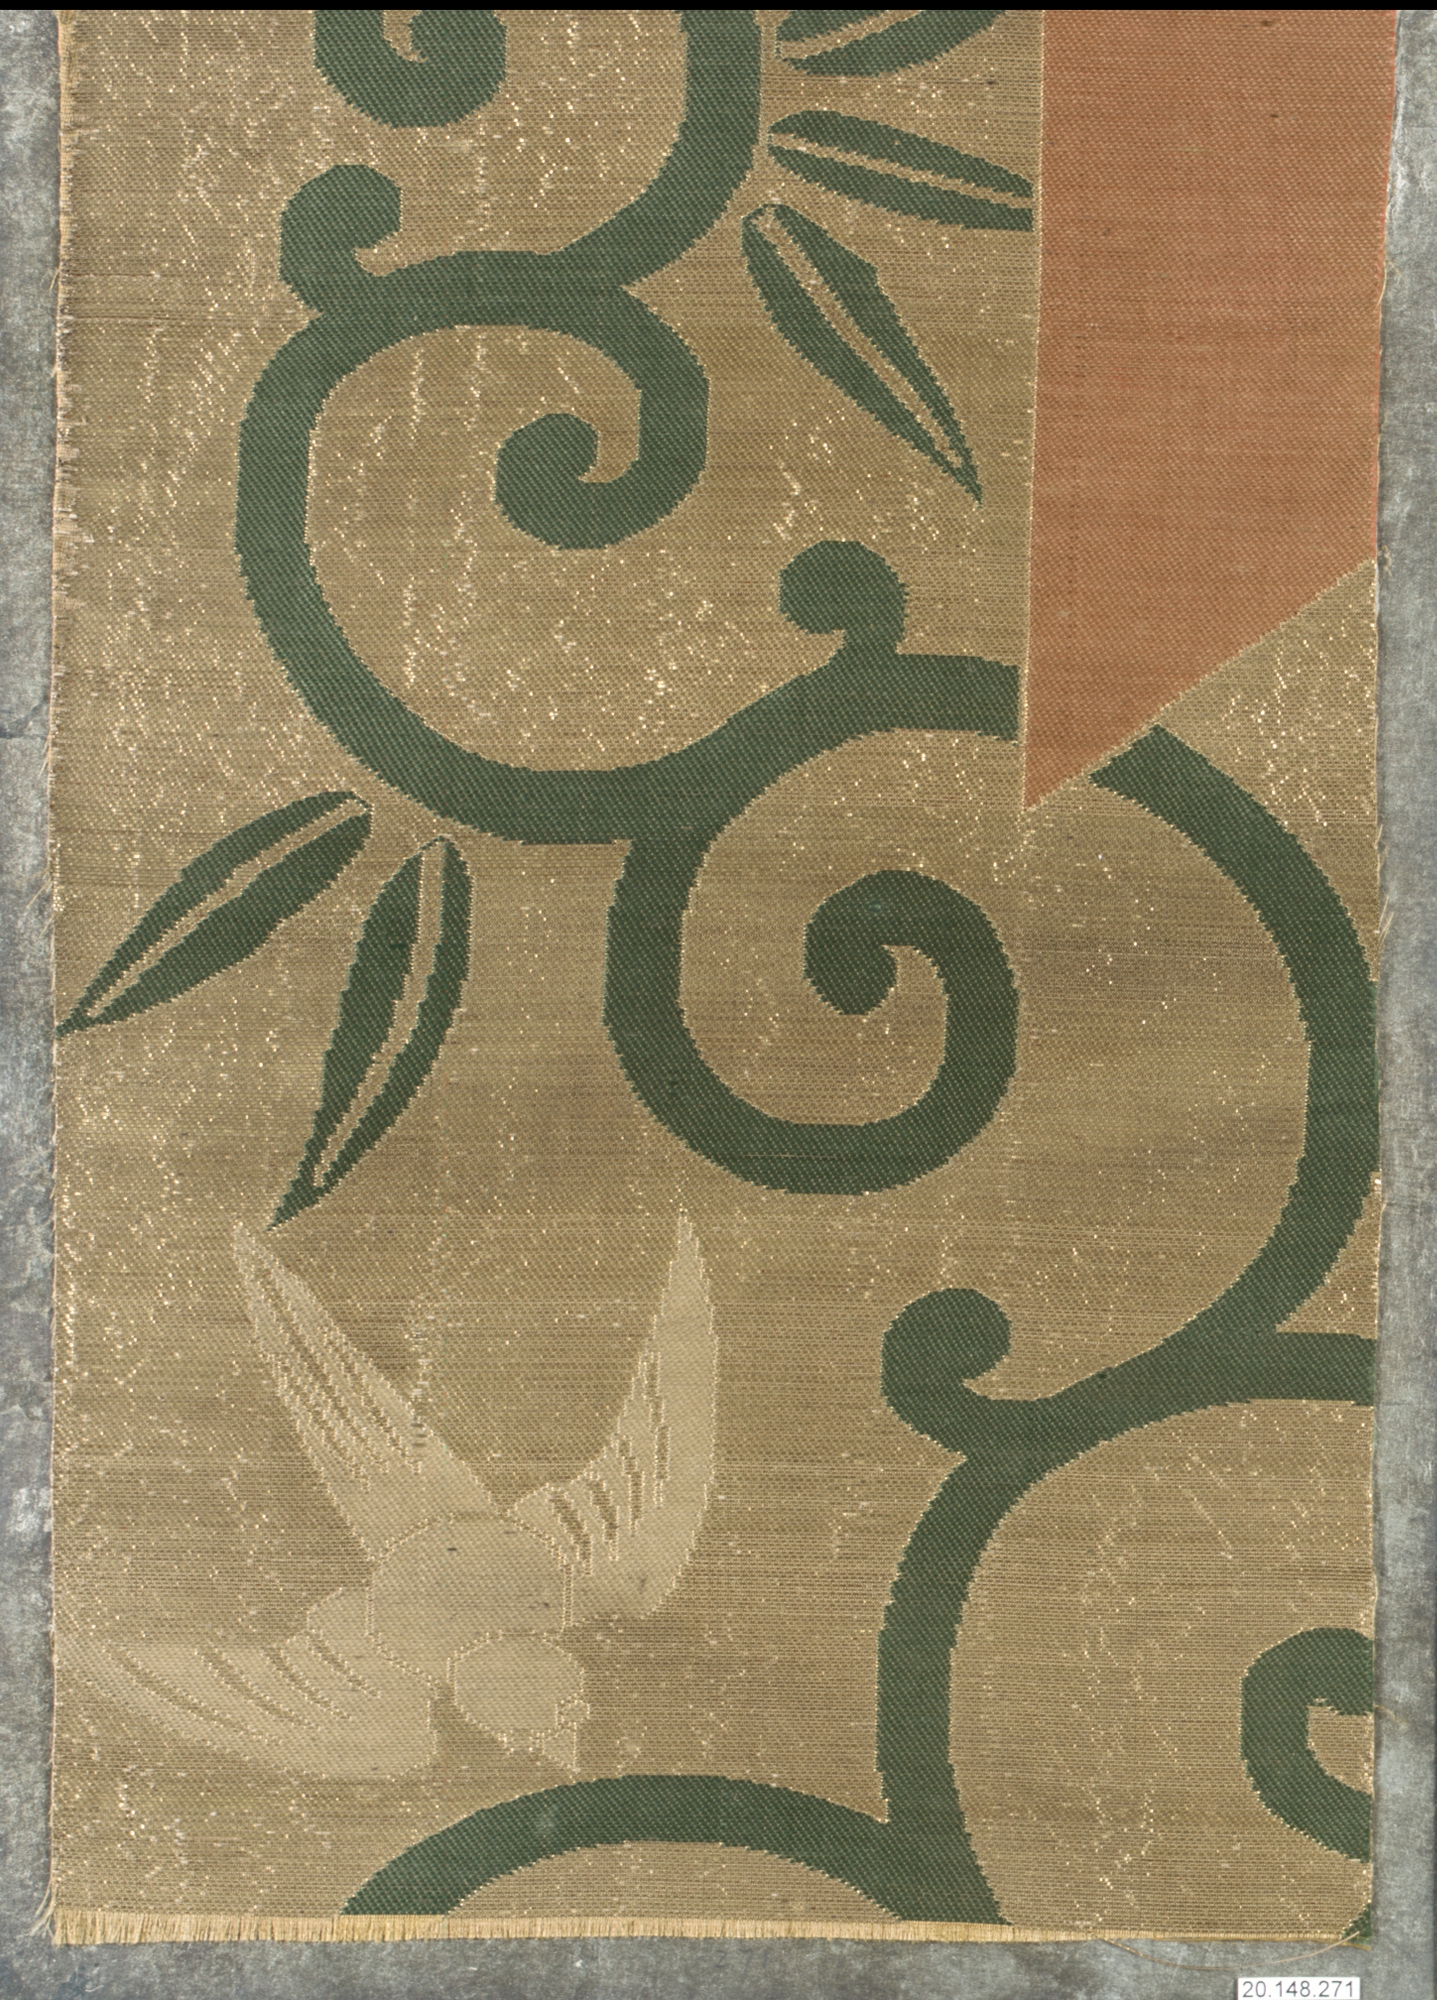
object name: piece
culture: japanese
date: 1701-1800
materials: silk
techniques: compound weave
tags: birds